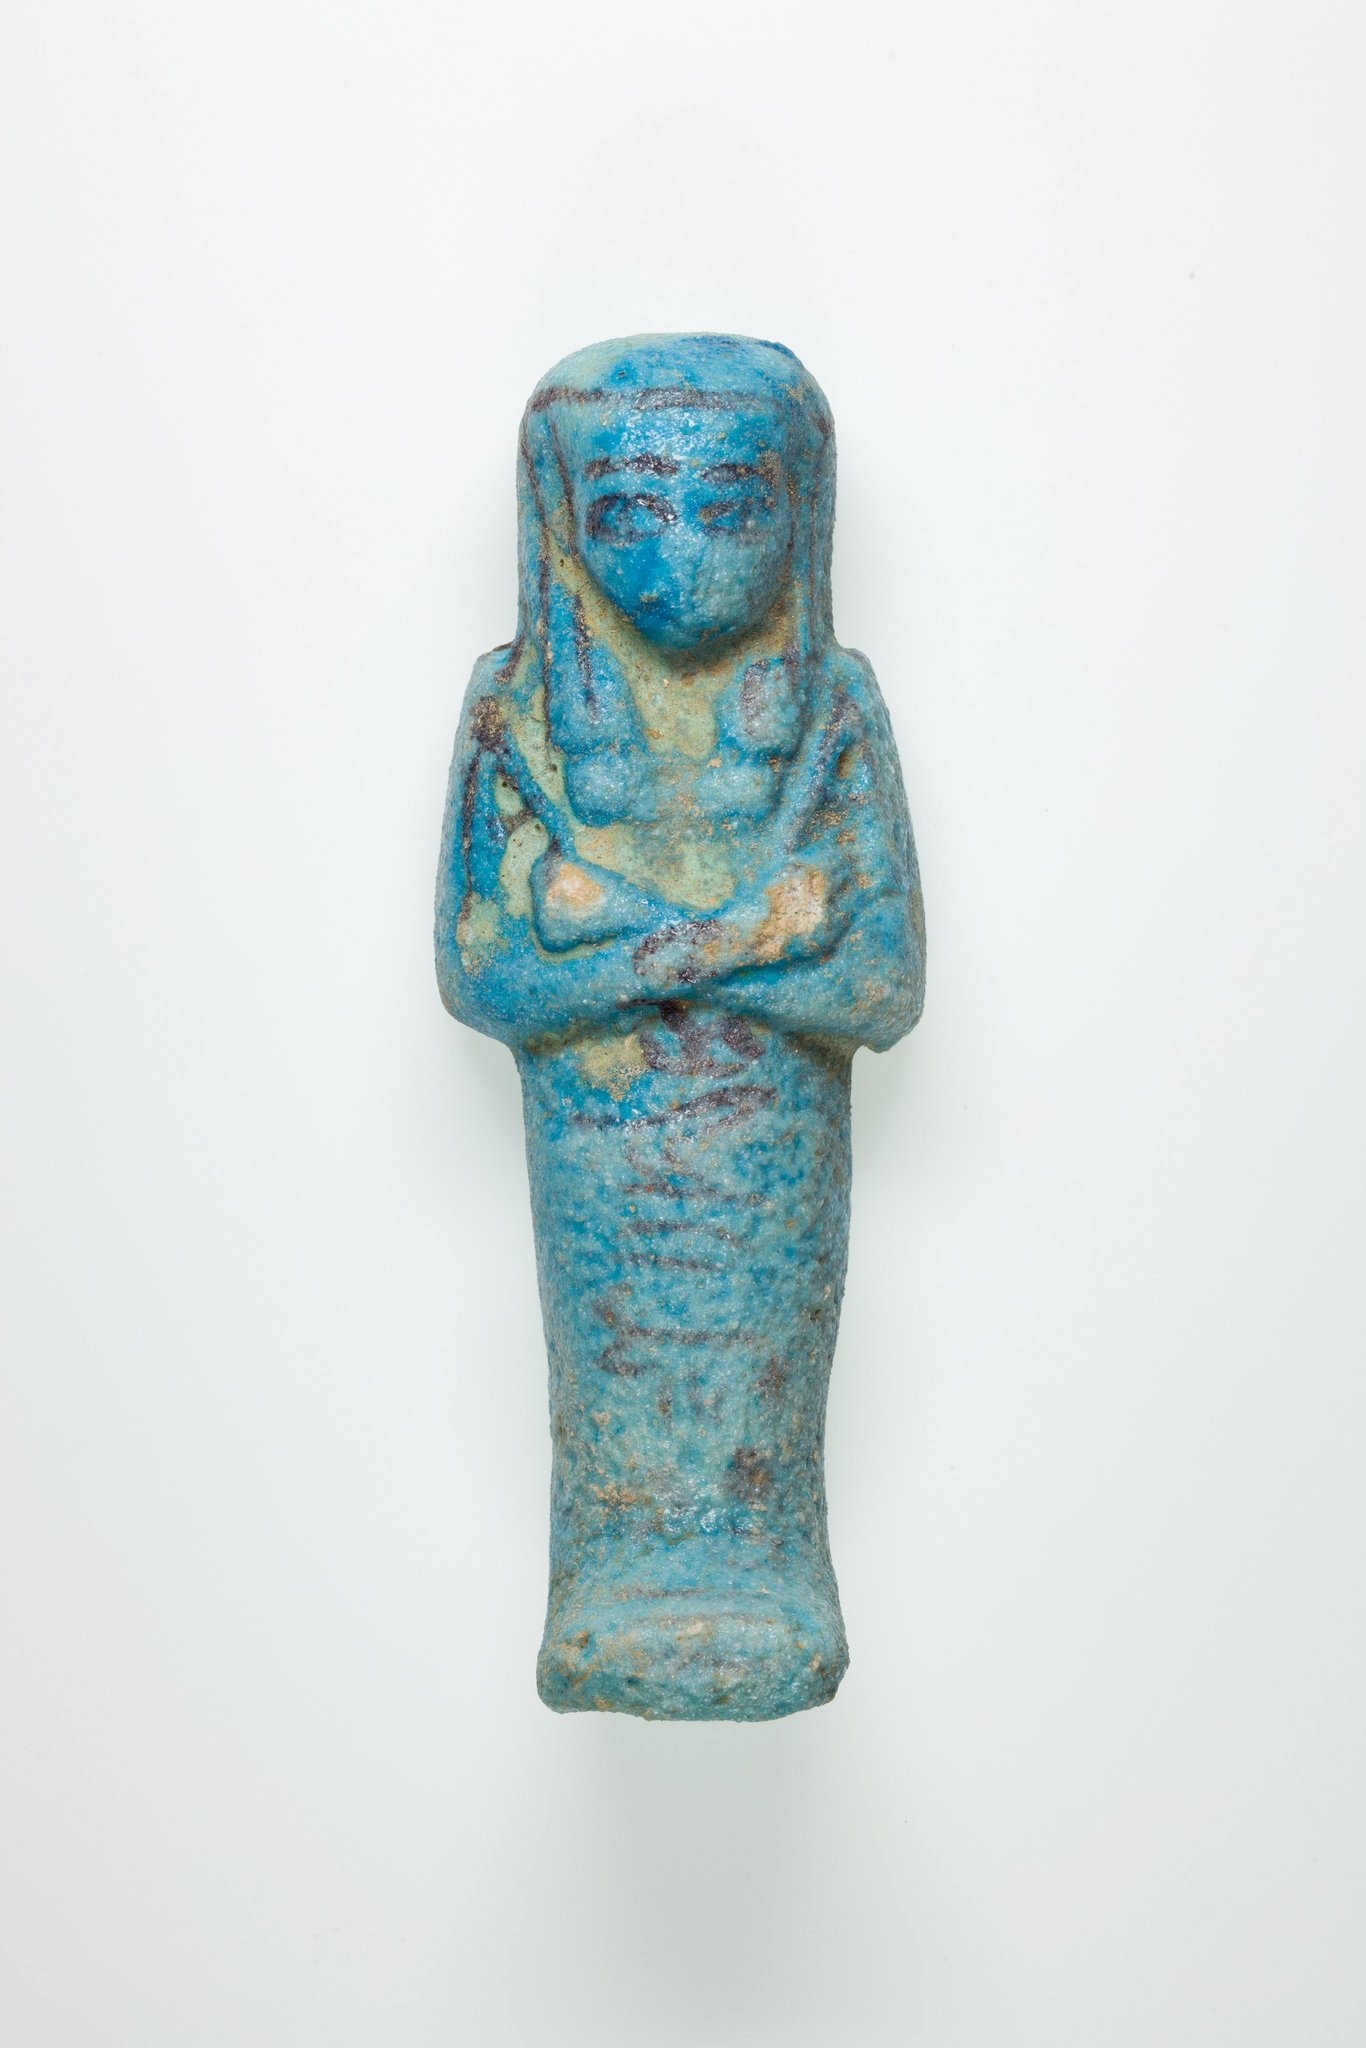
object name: worker shabti, henettawy c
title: Worker Shabti of Henettawy (C), Daughter of Isetemkheb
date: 990-970 BCE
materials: faience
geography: egypt